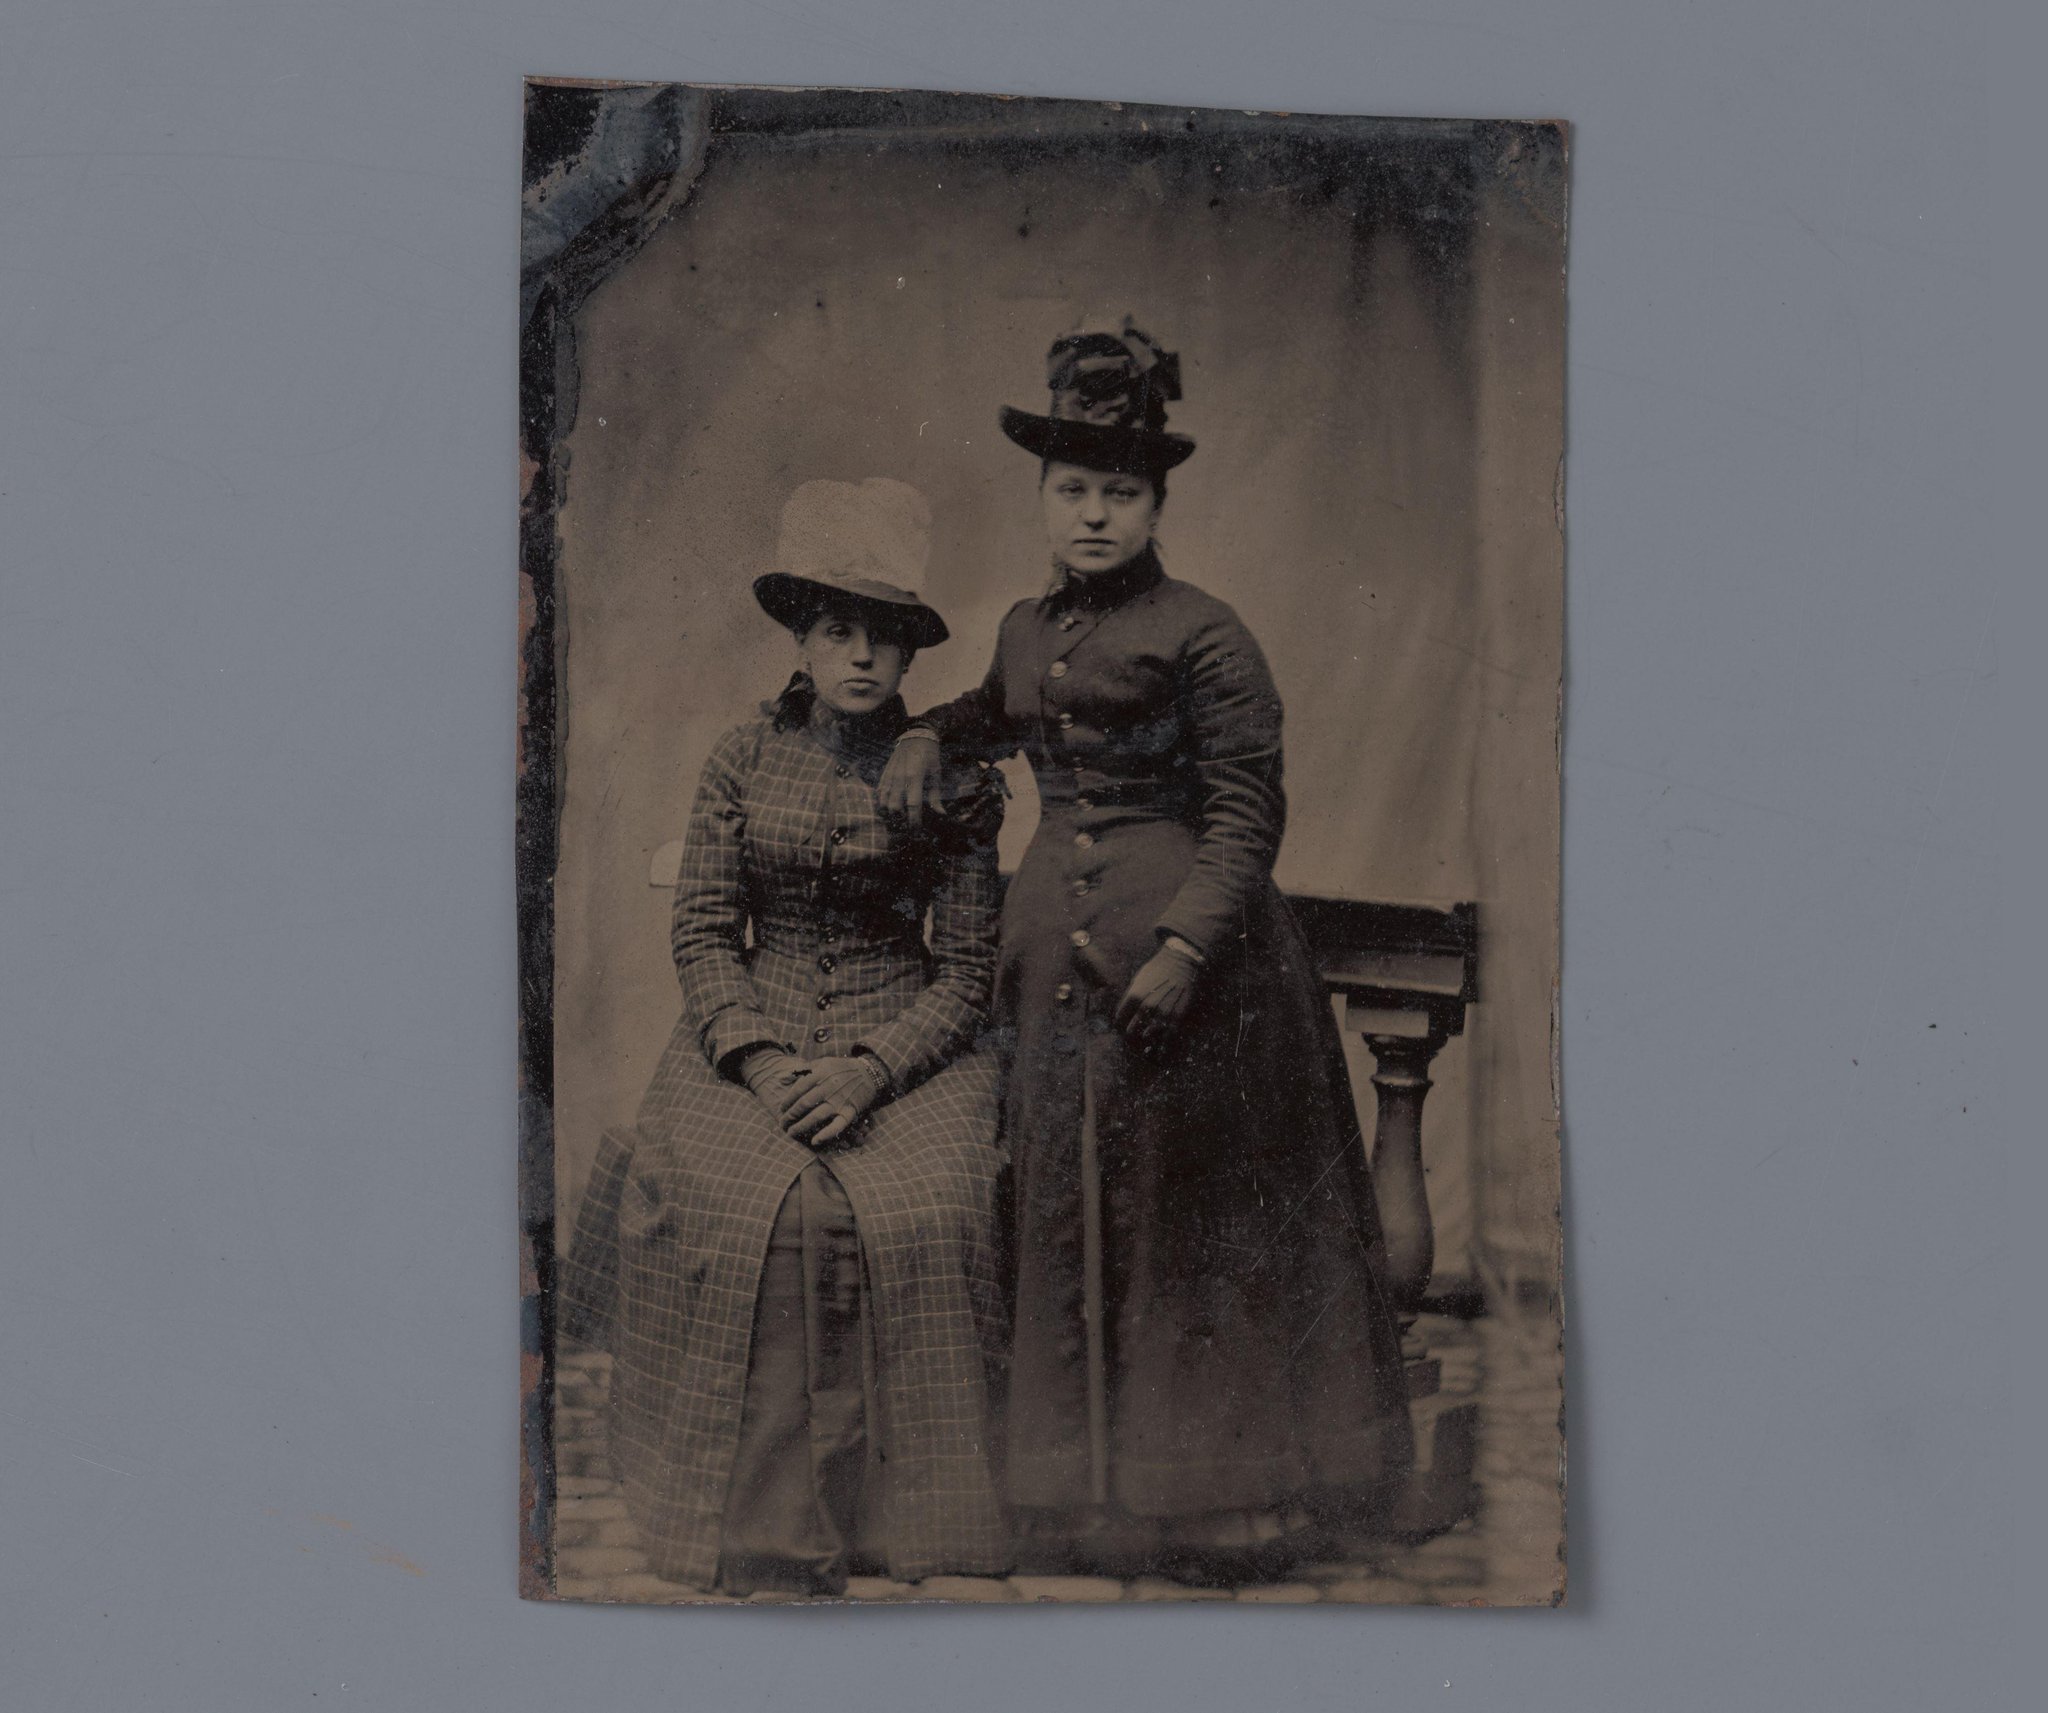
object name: photograph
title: Portrait of two unknown young women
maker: Anonymous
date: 1855-1940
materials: iron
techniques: ferrotyping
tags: historical persons - bb - woman, head-gear: hat, adolescent, young woman, maiden (+ two persons)